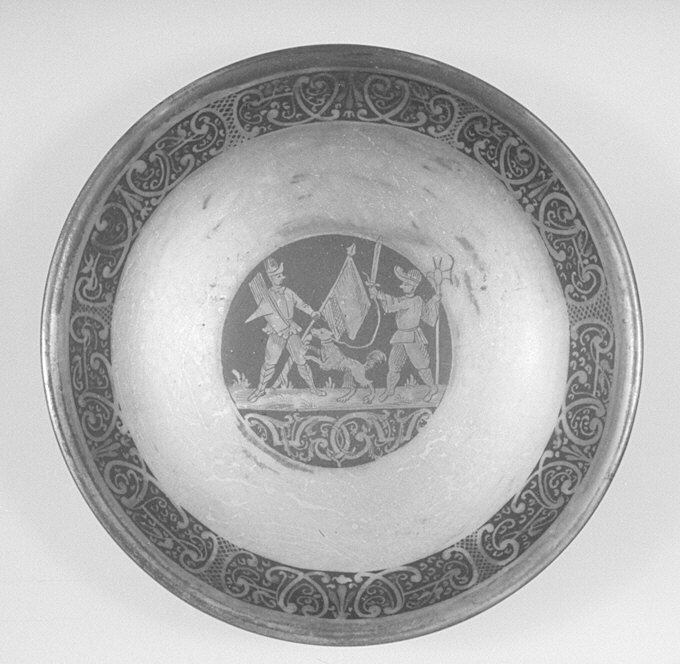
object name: saucer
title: Saucers (set of six) (part of a set)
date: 1726-1750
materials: earthenware, silver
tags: soldiers,swords,dogs,flags